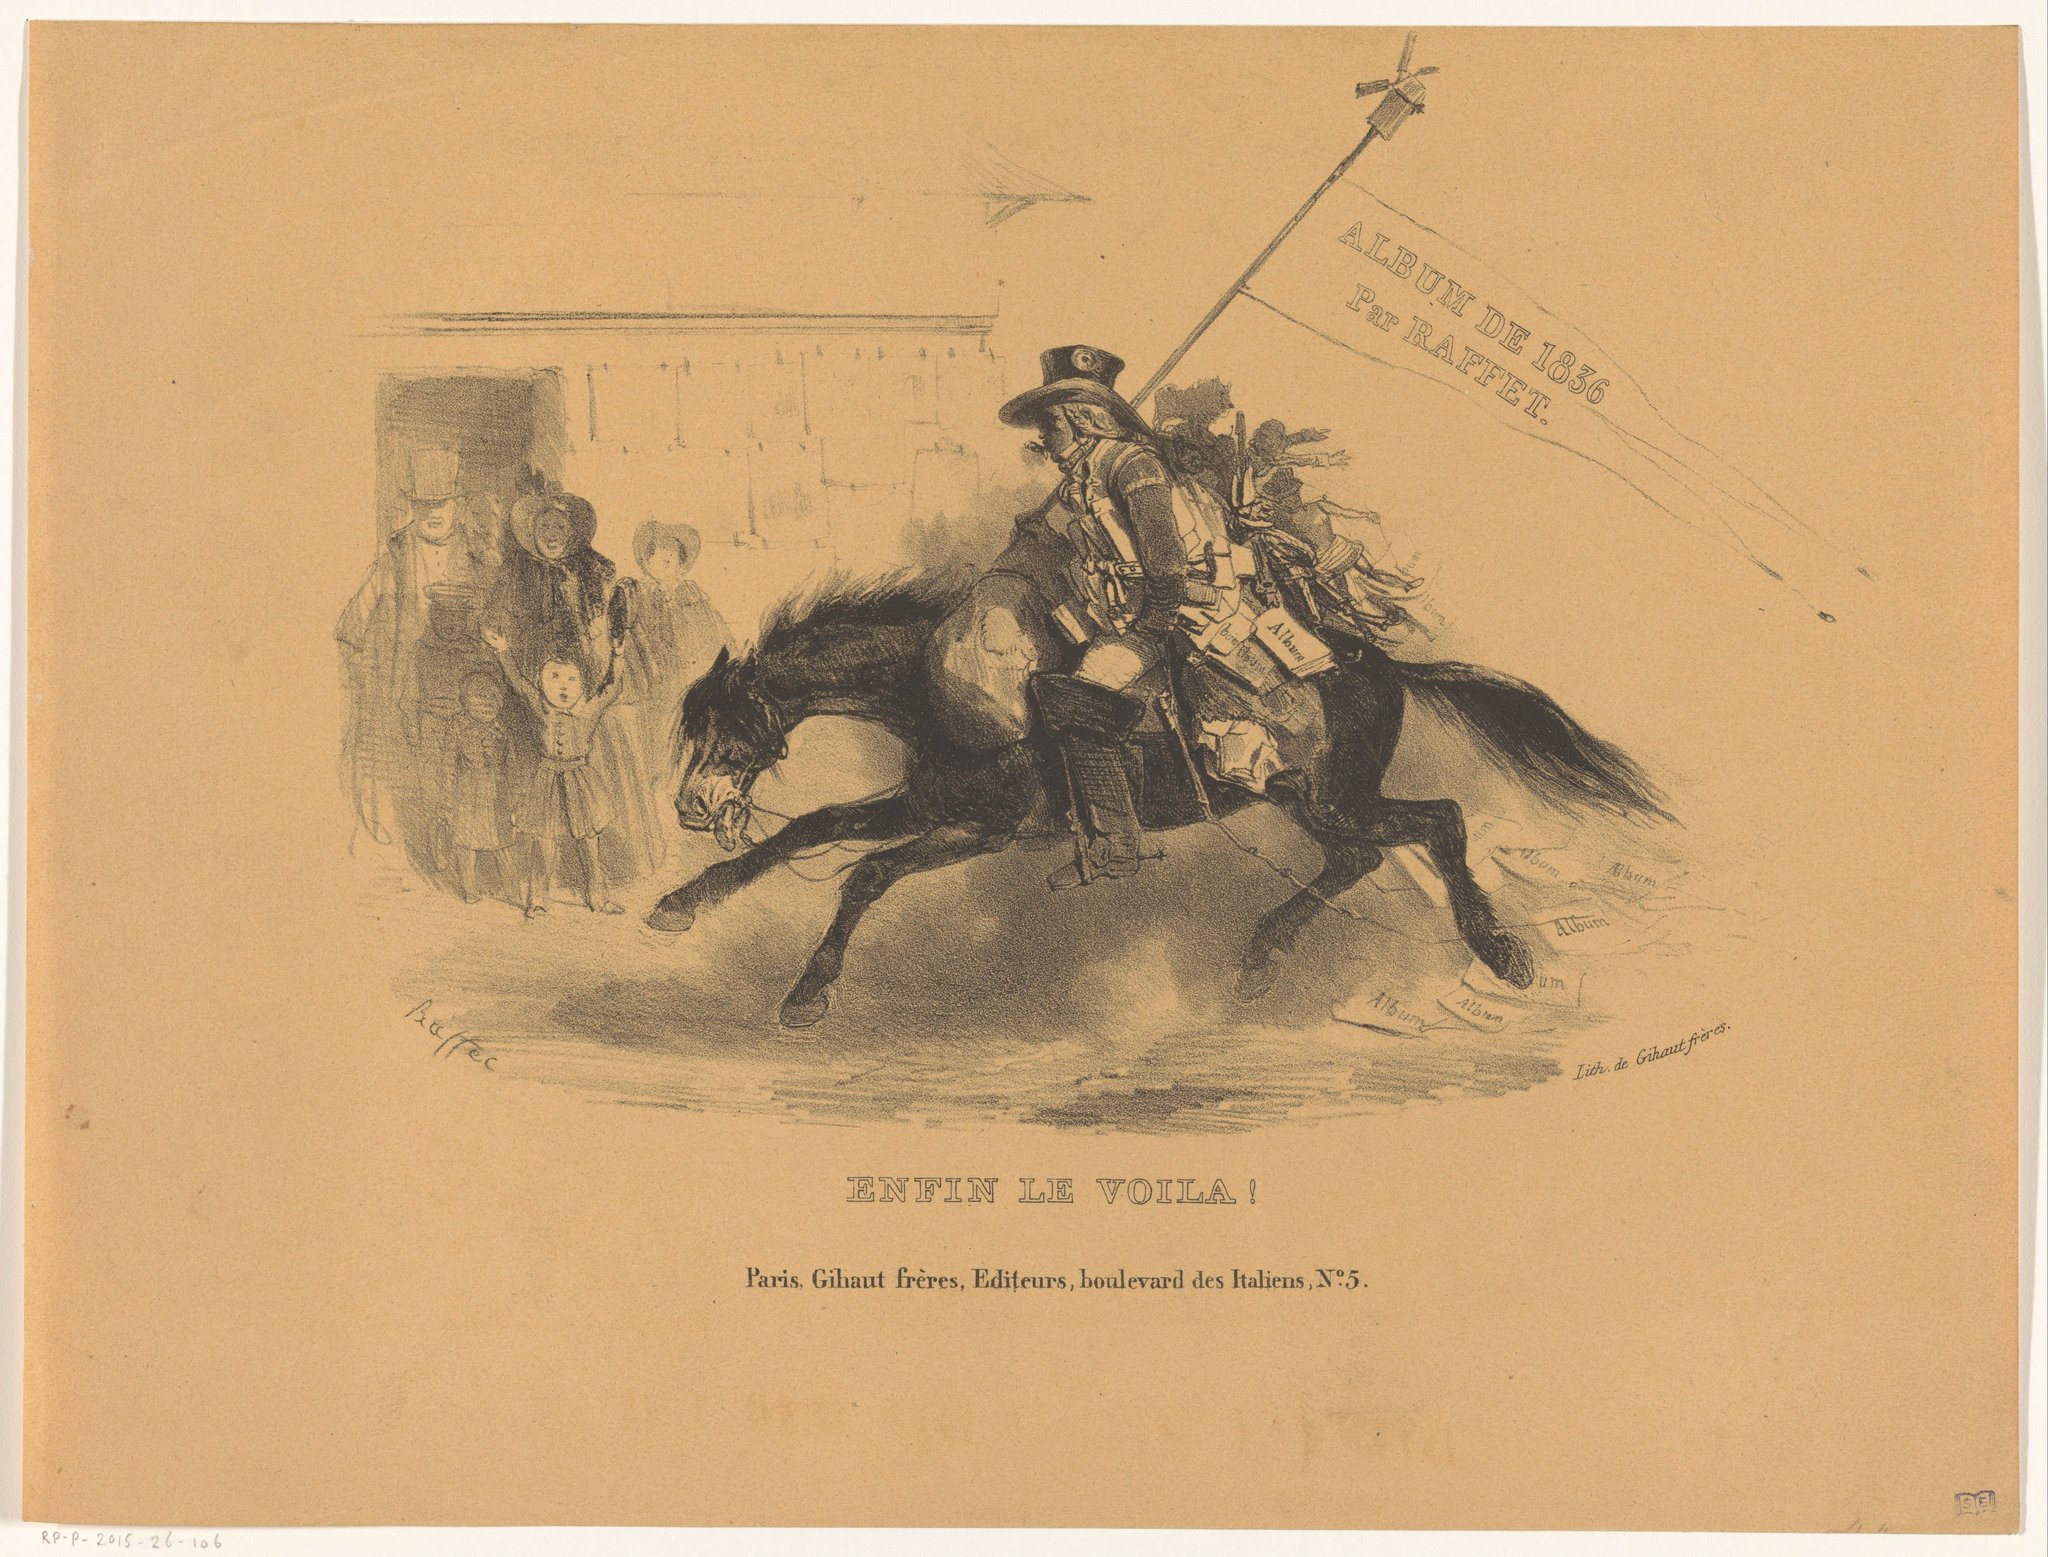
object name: titelprent, frontispice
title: Album de 1836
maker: denis auguste marie raffet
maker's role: draughtsman, print maker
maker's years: 1804-1860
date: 1836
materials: paper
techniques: lithograph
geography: paris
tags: messenger, horse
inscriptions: collector's mark: Lugt 4779, collector's mark: Lugt 2228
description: Een postiljon te paard, volgepakt met exemplaren van het Album van Raffet en andere zaken. Enkele exemplaren van het album zijn van het paard gevallen. In de achtergrond figuren voor een wand vol prenten.